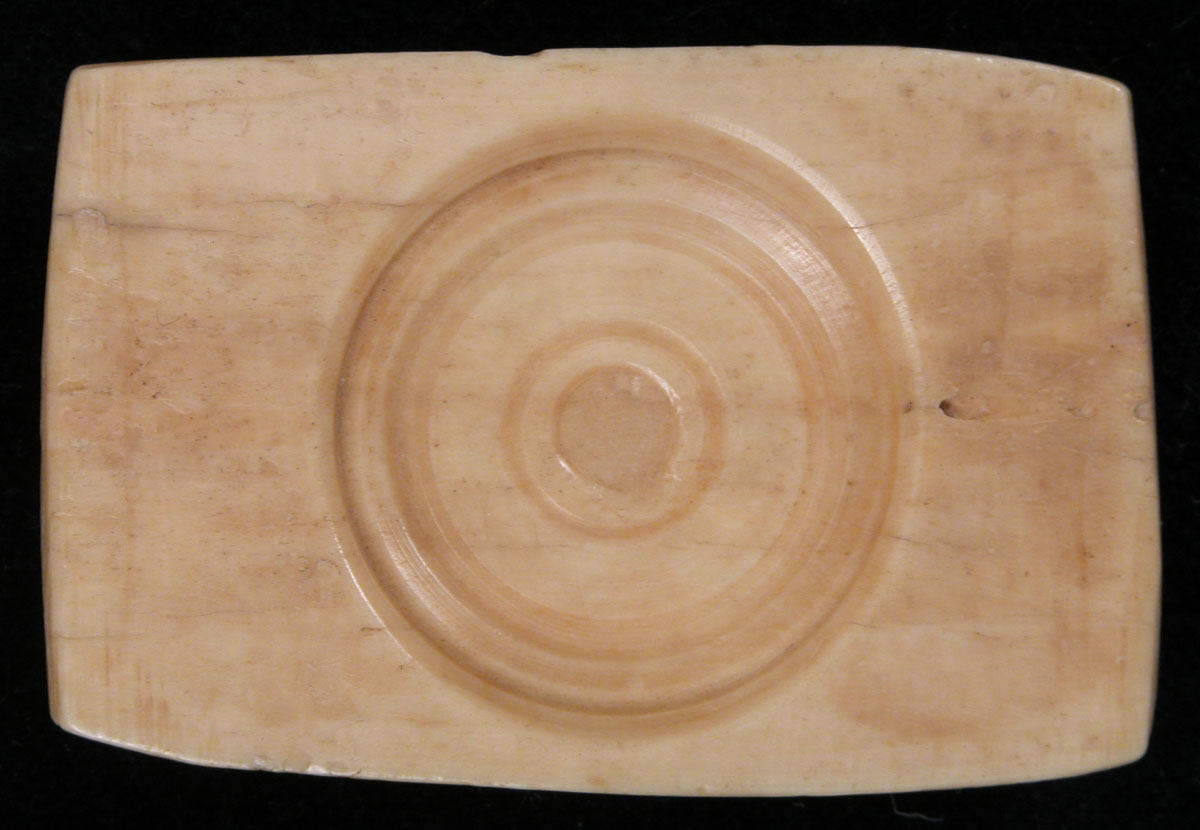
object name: counter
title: Probably a Counter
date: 401-800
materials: bone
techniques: carving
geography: palestine